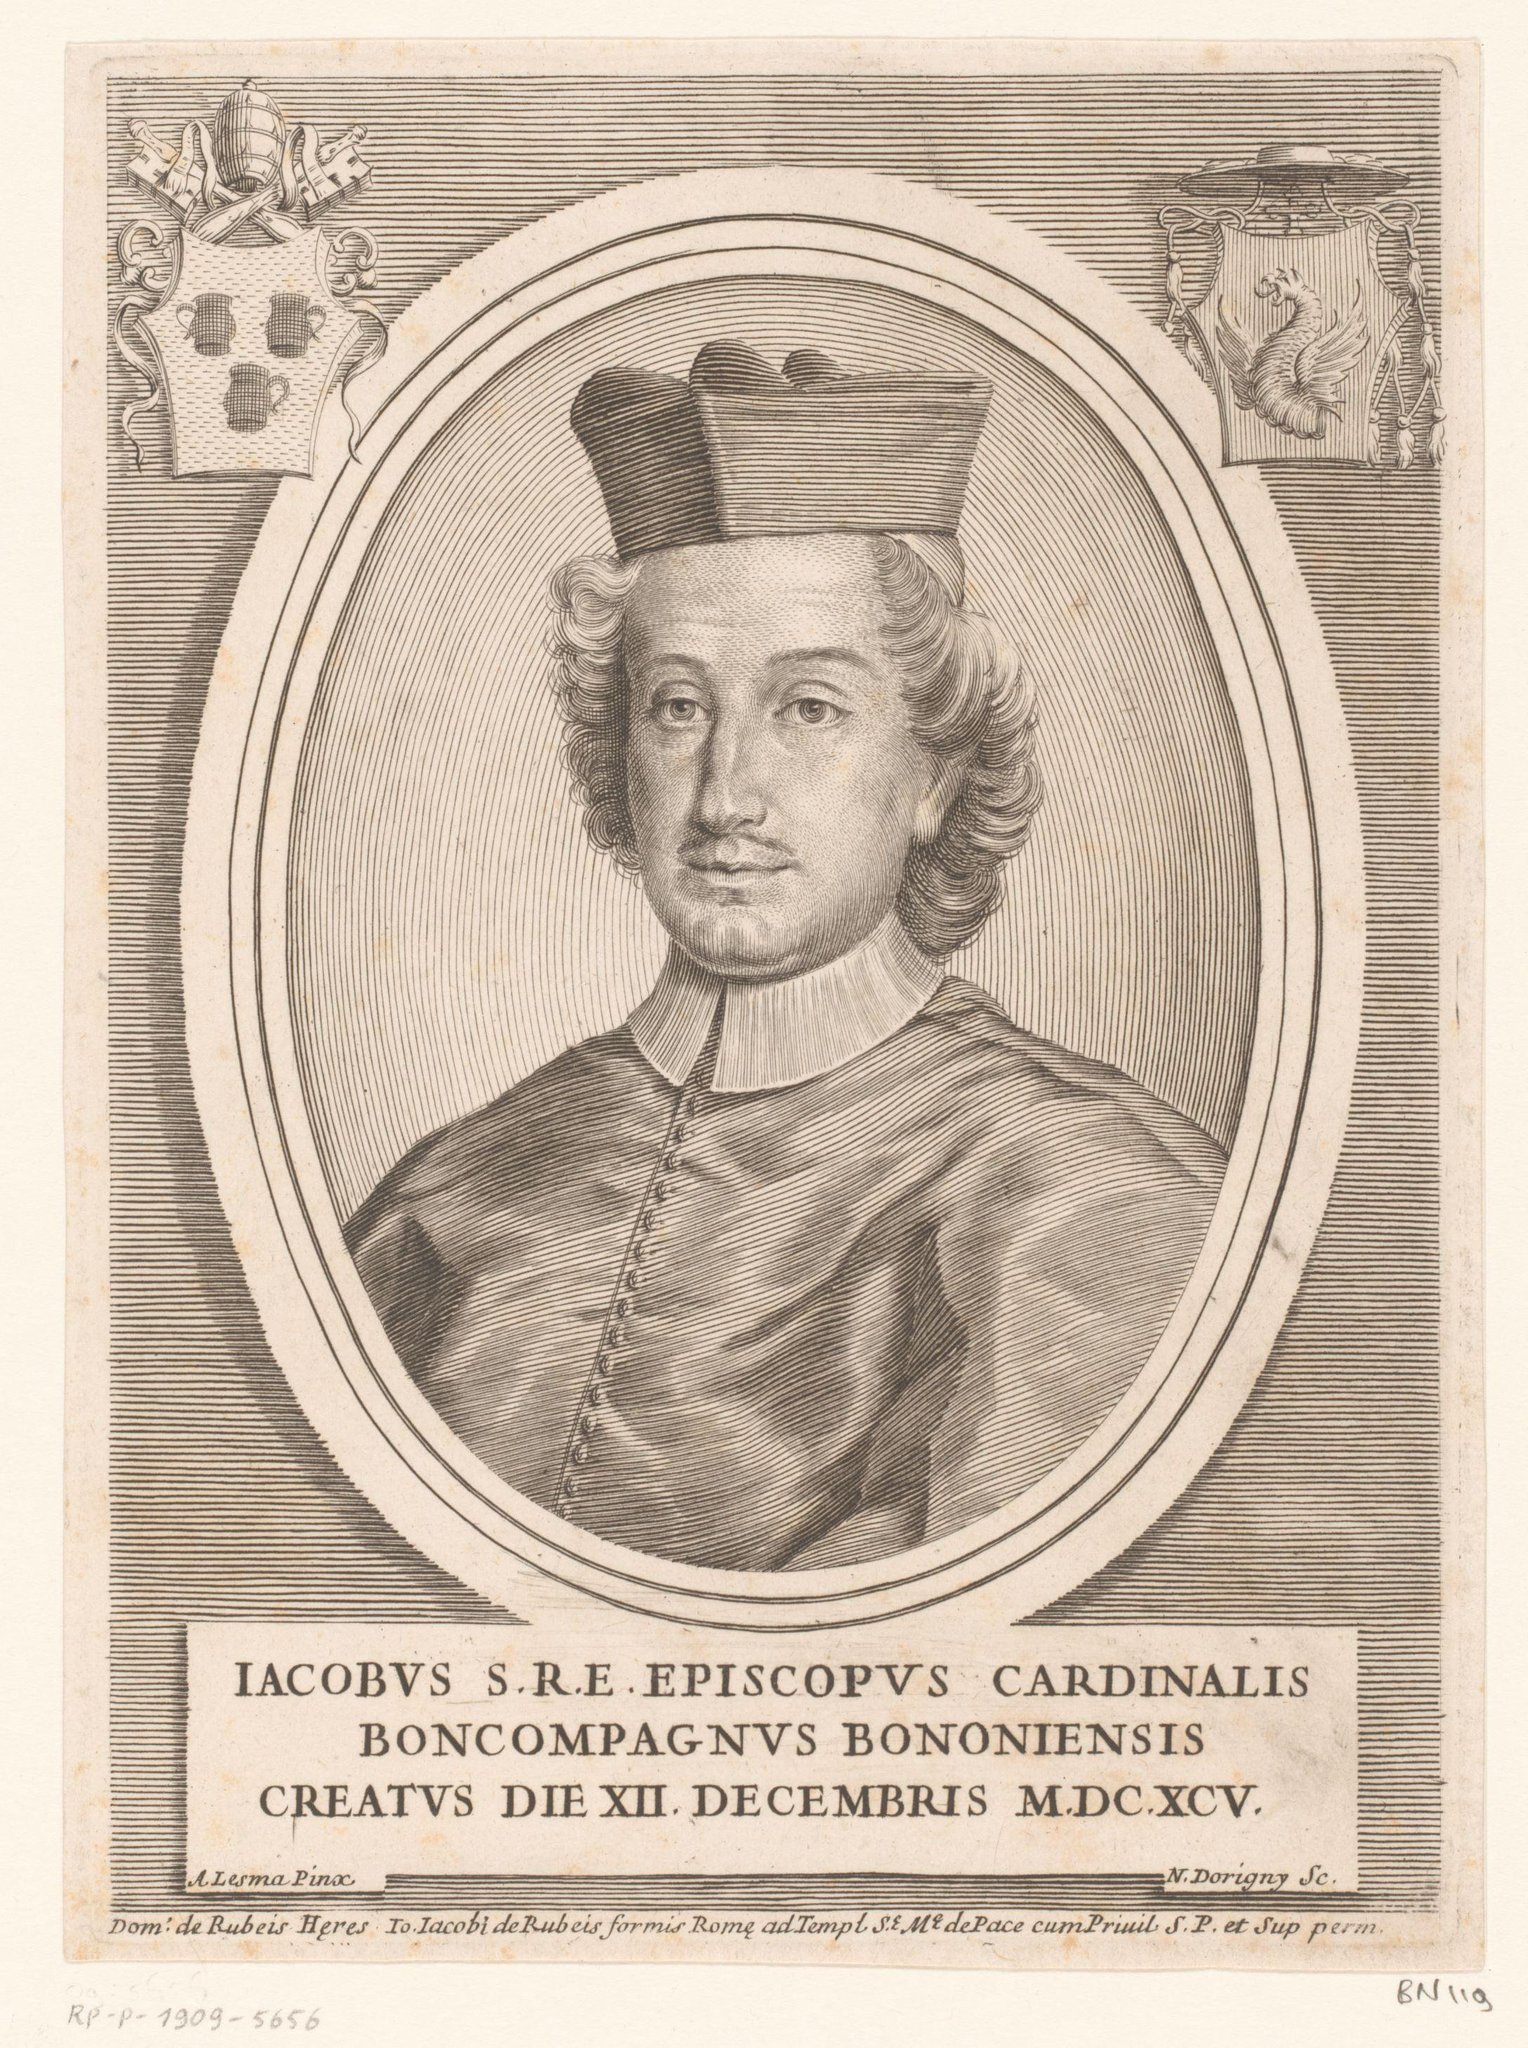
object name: print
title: Portret van Giacomo Boncompagni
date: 1695-1700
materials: paper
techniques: engraving, etching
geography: france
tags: ornament ~ medallion, cardinal, historical persons, armorial bearing, heraldry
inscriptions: collector's mark: Lugt 2228